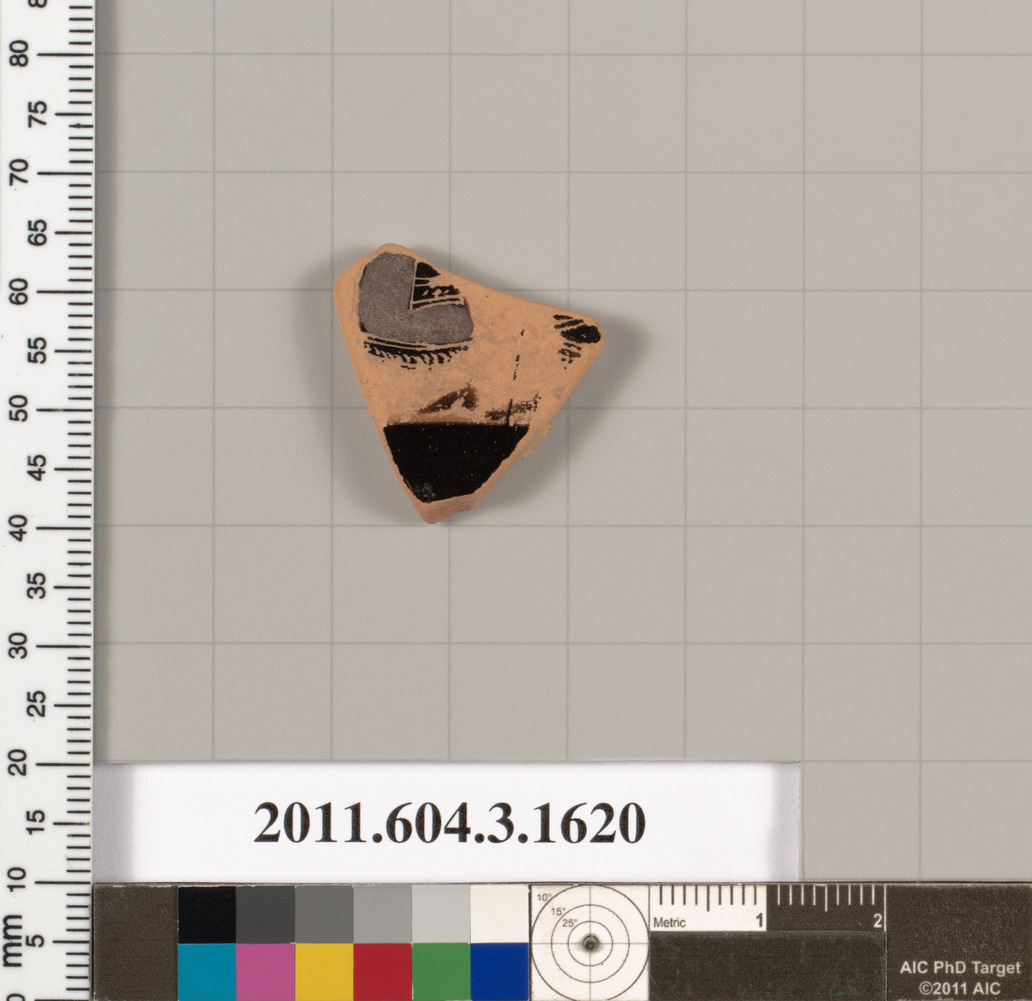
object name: kylix fragment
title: Terracotta fragment of a kylix: Band cup (drinking cup)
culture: greek, attic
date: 567-535 BCE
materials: terracotta